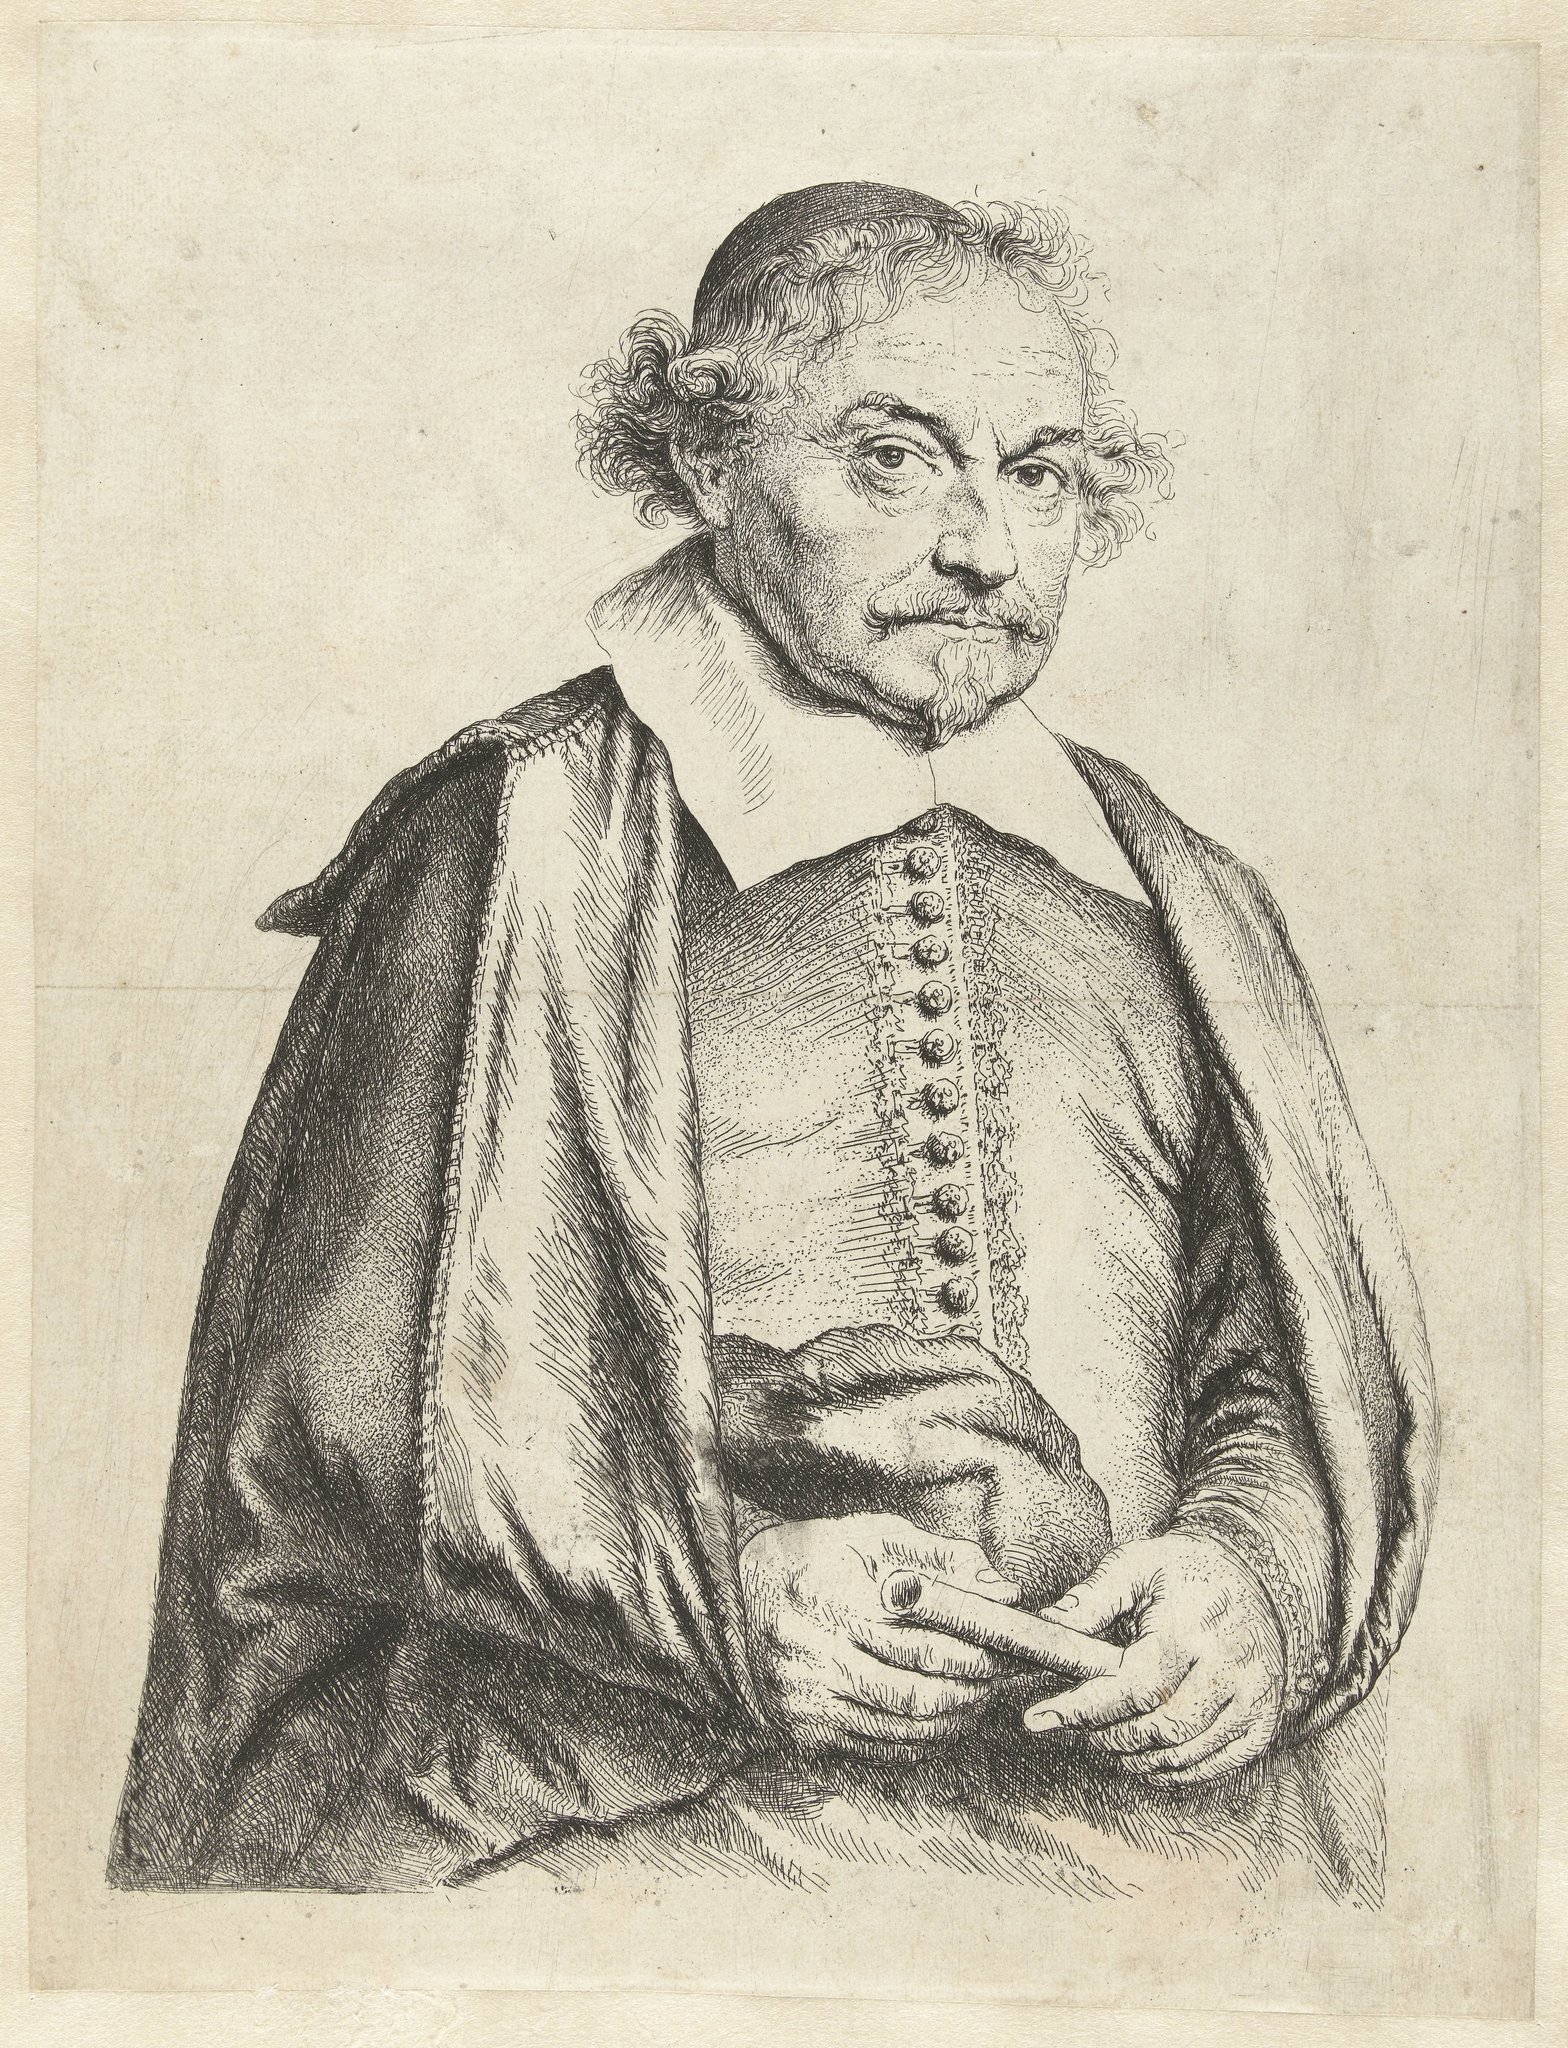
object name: print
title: Portret van Joost van den Vondel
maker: jan lievens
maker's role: draughtsman, painter, print maker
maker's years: 1607-1674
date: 1644-1650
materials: paper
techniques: etching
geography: netherlands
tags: joost van den vondel, portrait of a writer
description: Portret van de schrijver en dichter Joost van dan Vondel, ten halven lijve, met een rol papier in zijn handen. Een witte achtergrond.